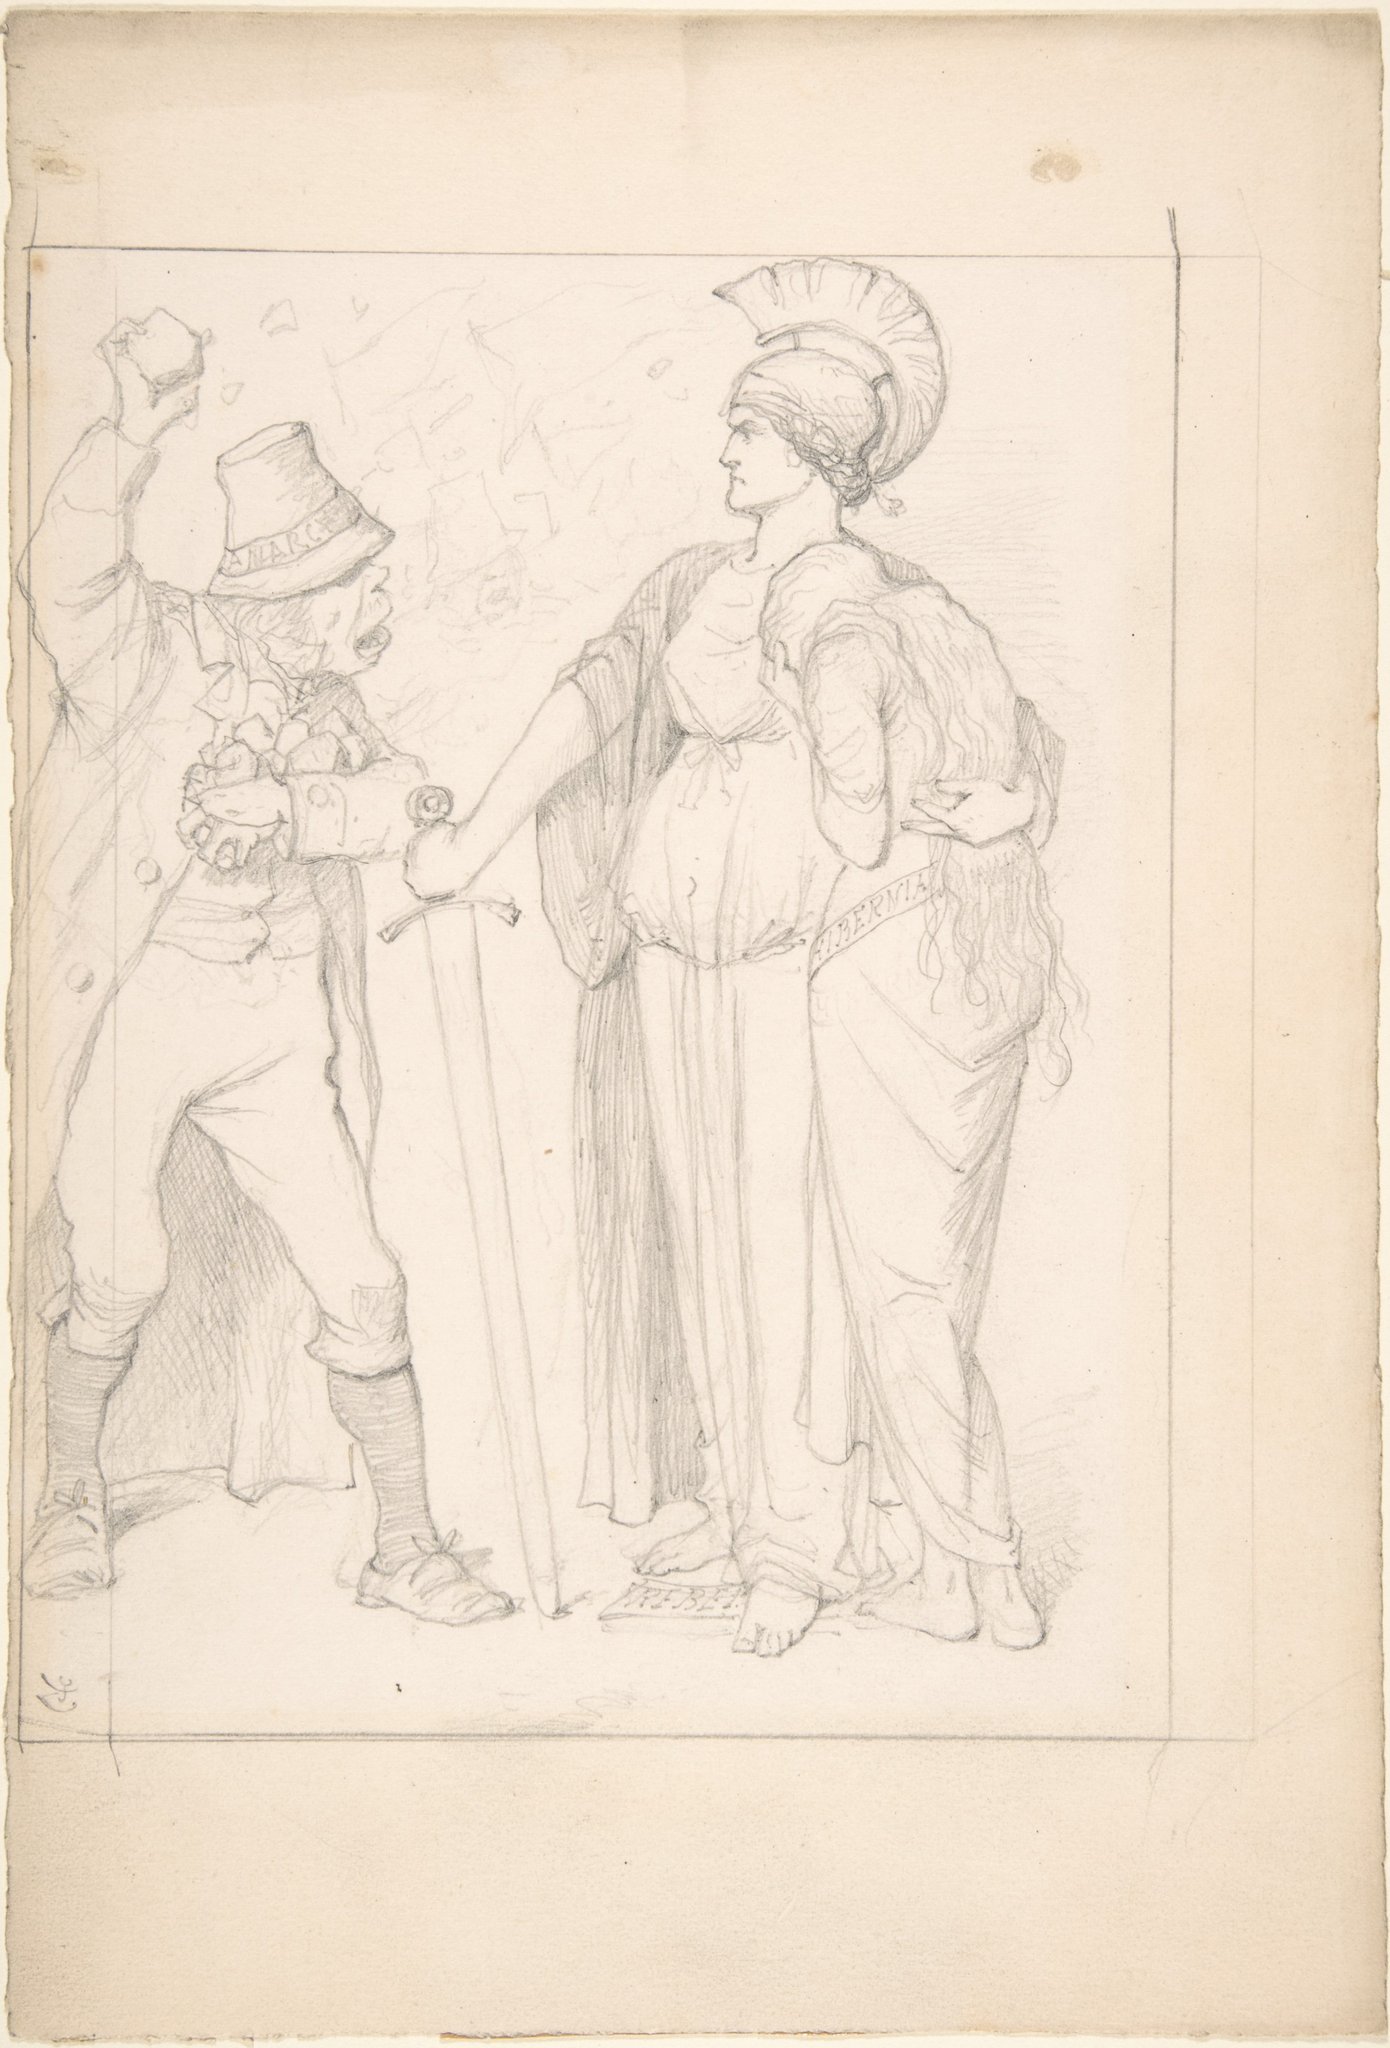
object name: drawing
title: Two Forces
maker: sir john tenniel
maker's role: artist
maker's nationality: british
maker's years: 1820-1914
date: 1881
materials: graphite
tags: swords,kings,women